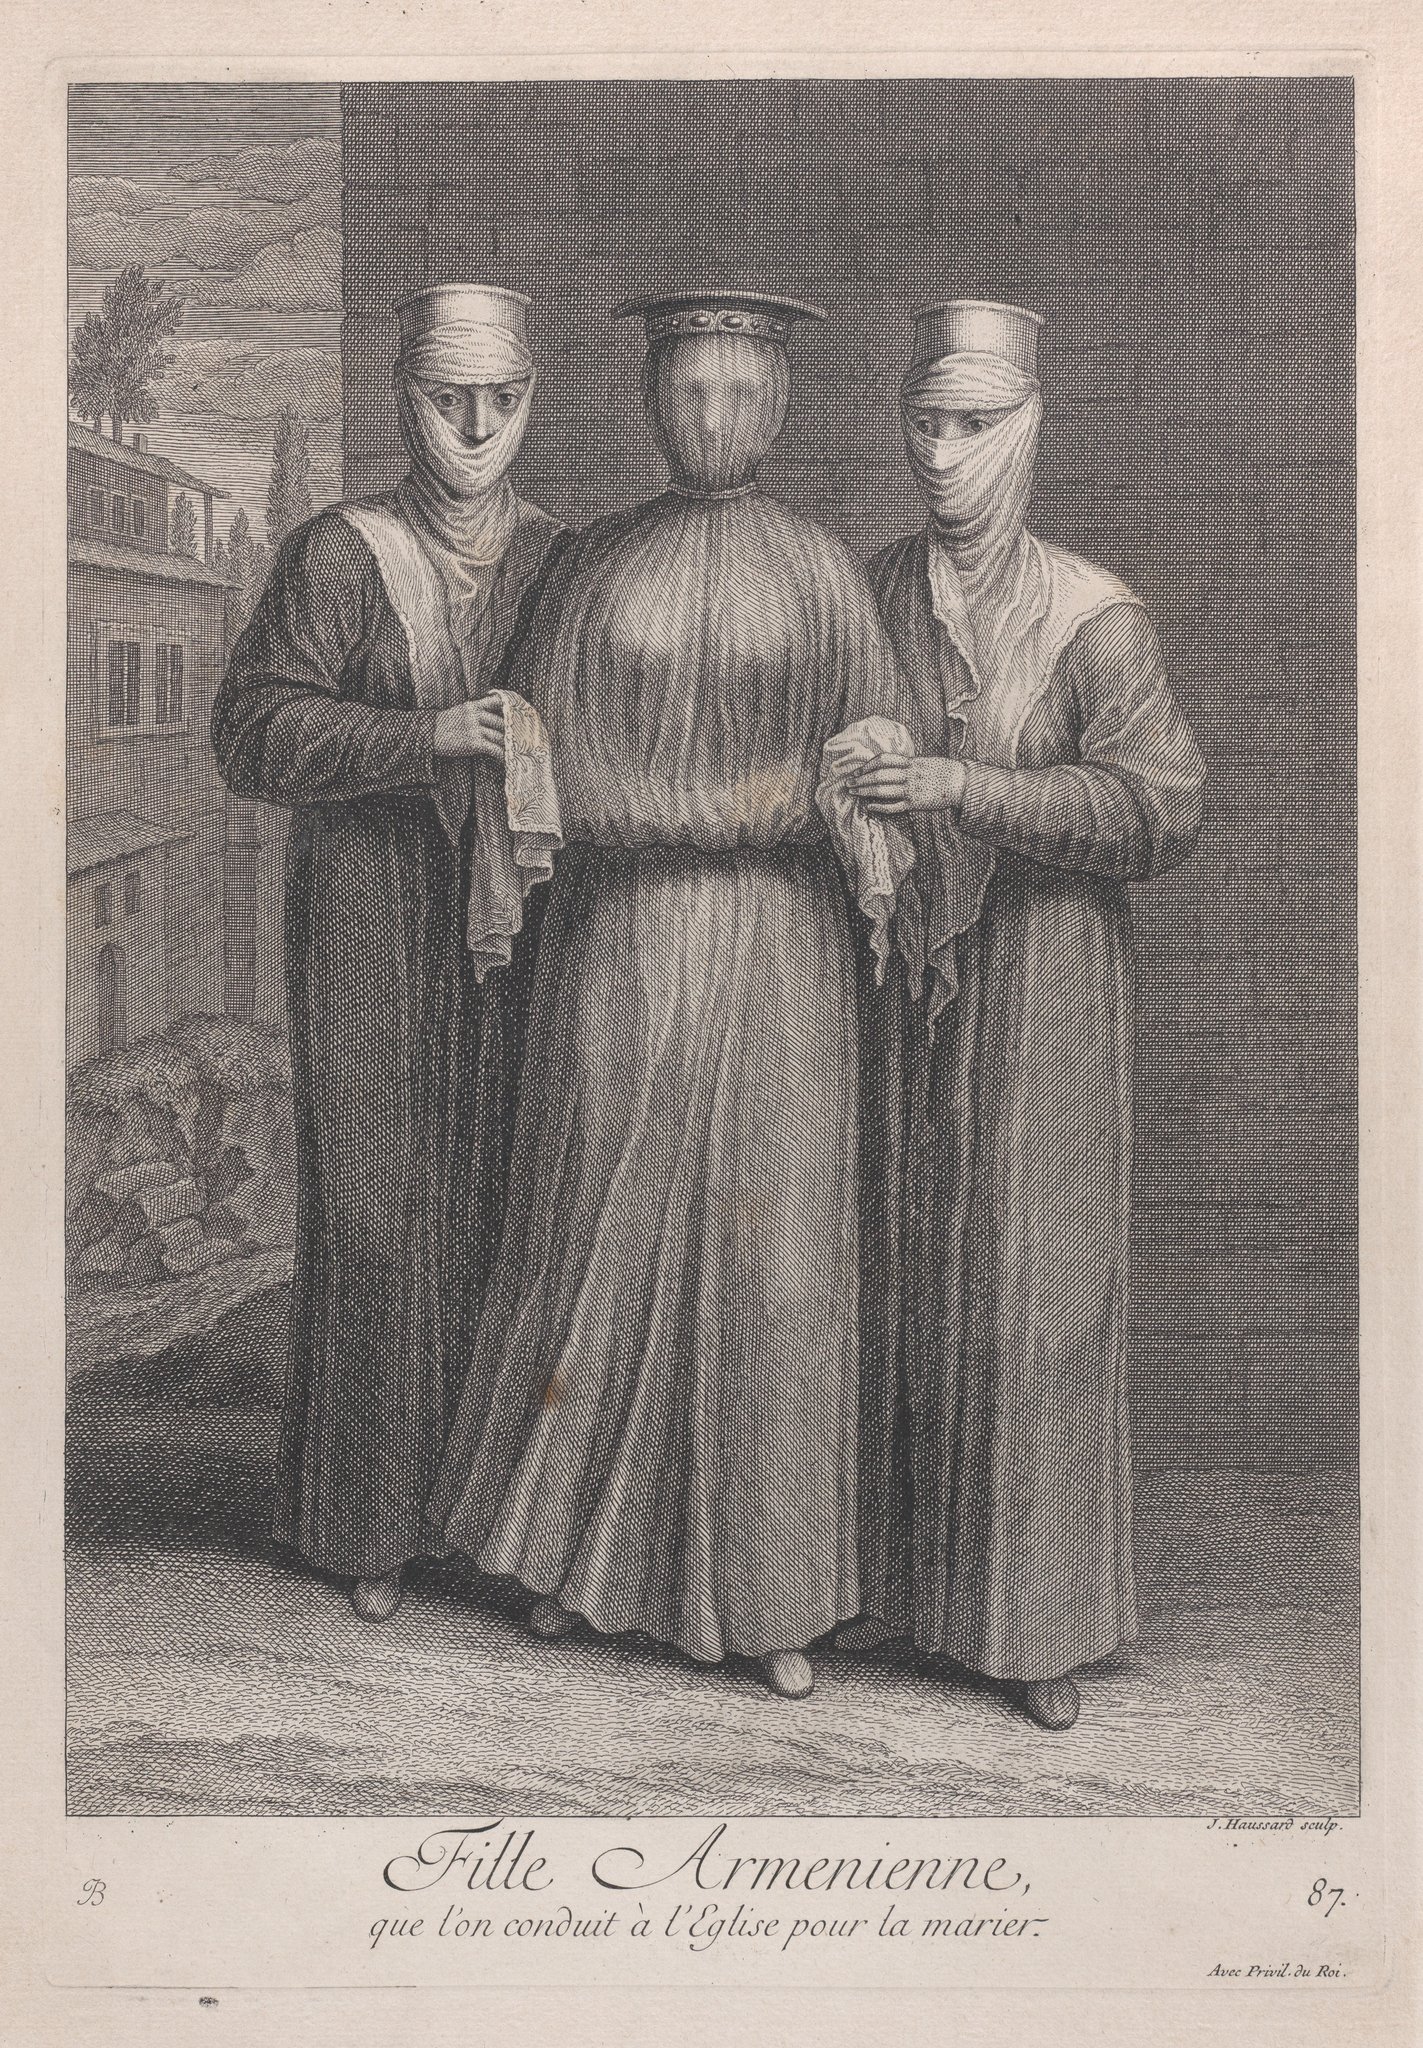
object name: print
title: Fille Armenienne, que l'on conduit à l'Eglise pour la marier, plate 87 from "Recueil de cent estampes représentent differentes nations du Levant"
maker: jean baptiste vanmour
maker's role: artist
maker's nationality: french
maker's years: 1671-1737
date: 1714-1715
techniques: engraving, etching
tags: women